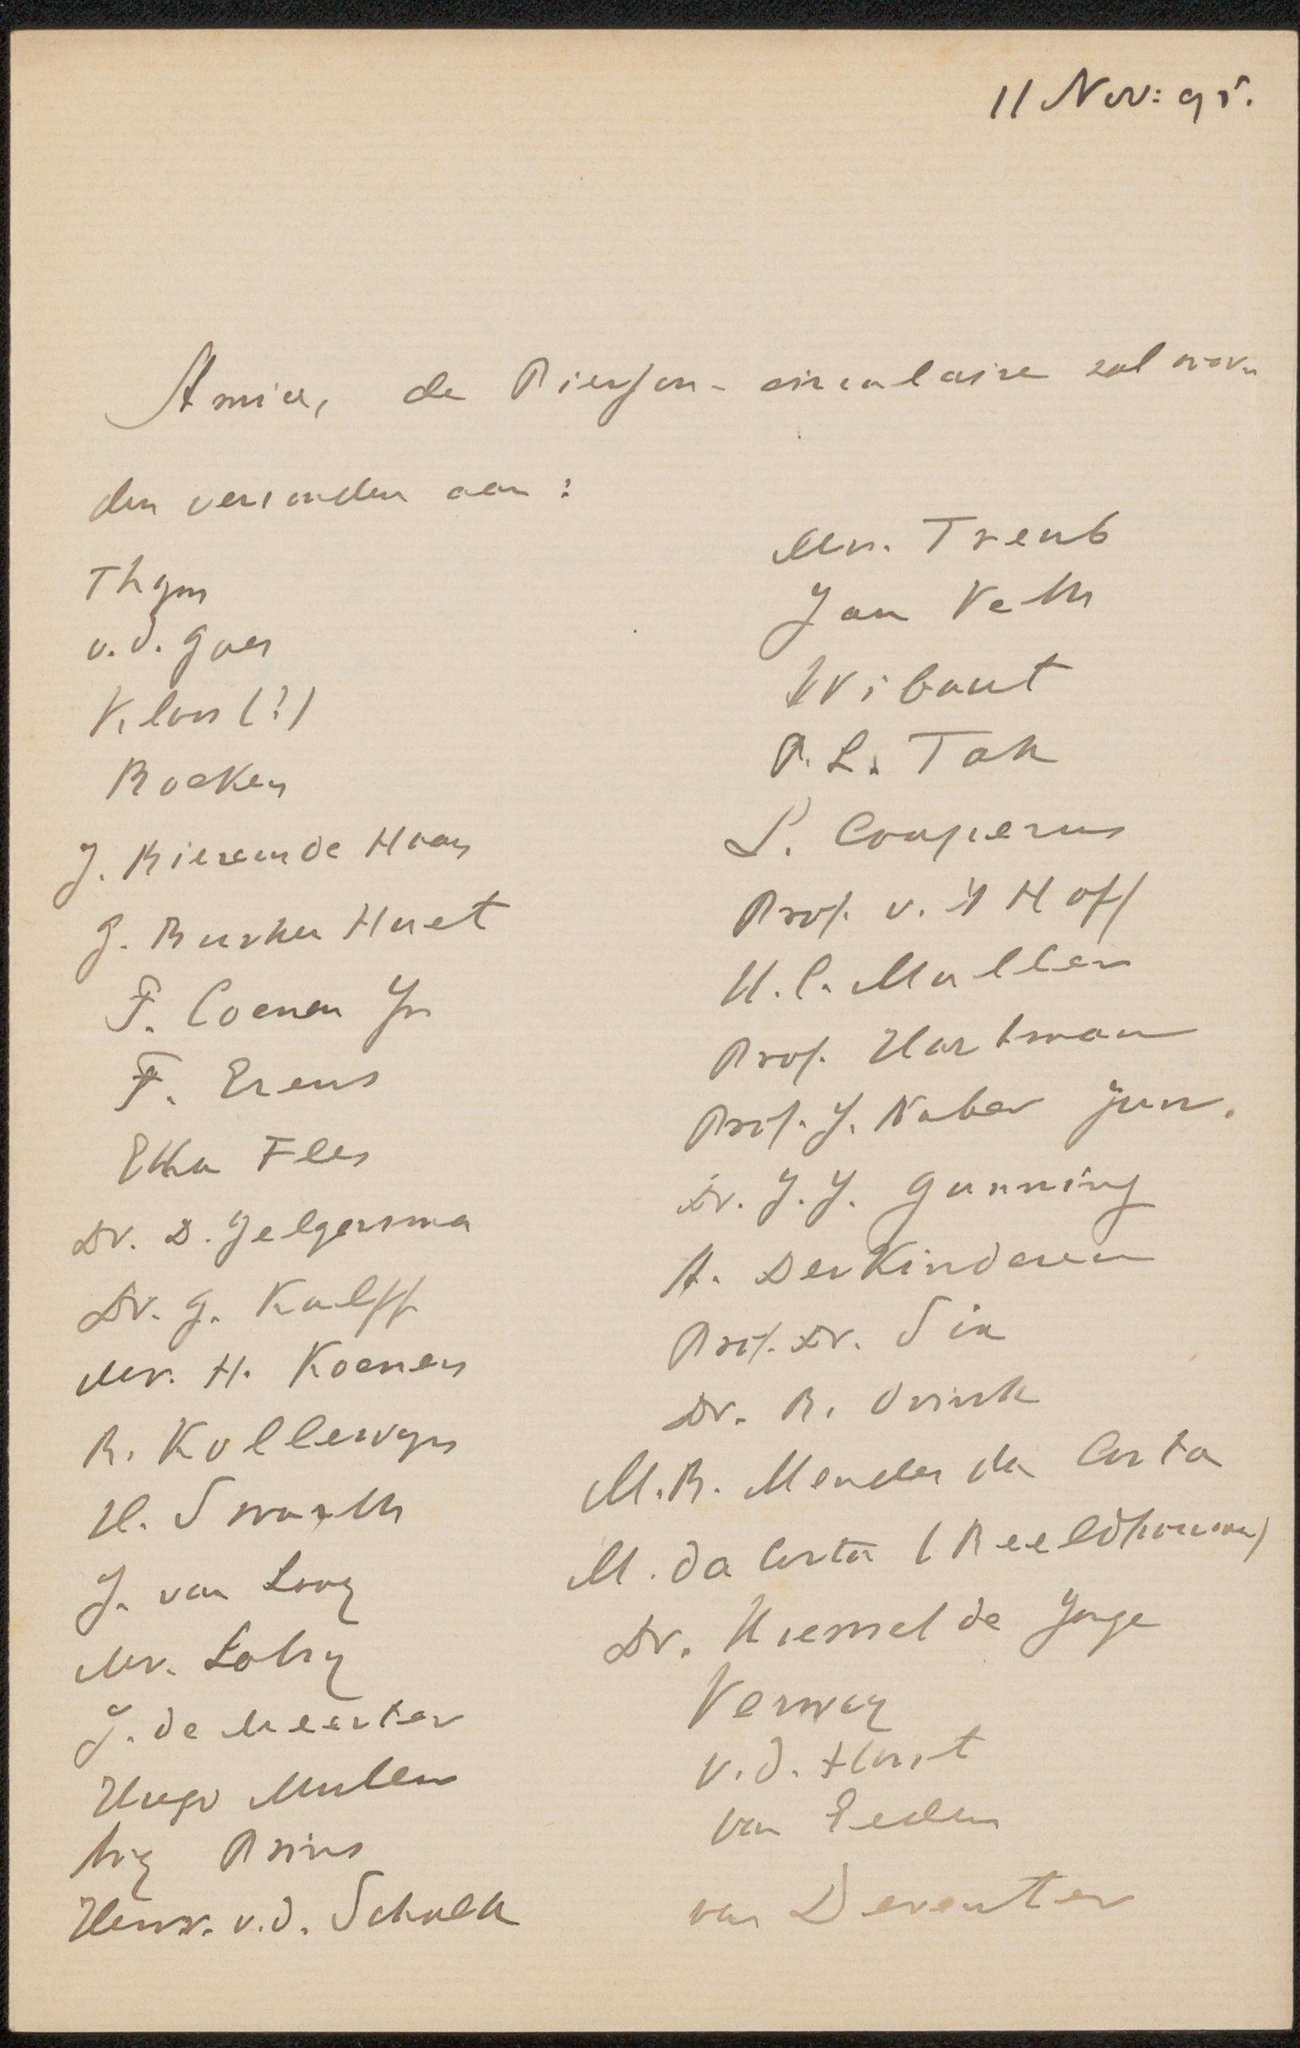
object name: letter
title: Brief aan Jan Veth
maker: chap van deventer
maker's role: kunstcriticus, scheikundige, schrijver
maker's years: 1860-1931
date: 1895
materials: ink, paper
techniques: pen, writing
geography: amsterdam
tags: painter, draughtsman, designer, jan veth, amsterdam, allard pierson, literature ~ arts, printed matter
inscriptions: collector's mark: ‘RPK’